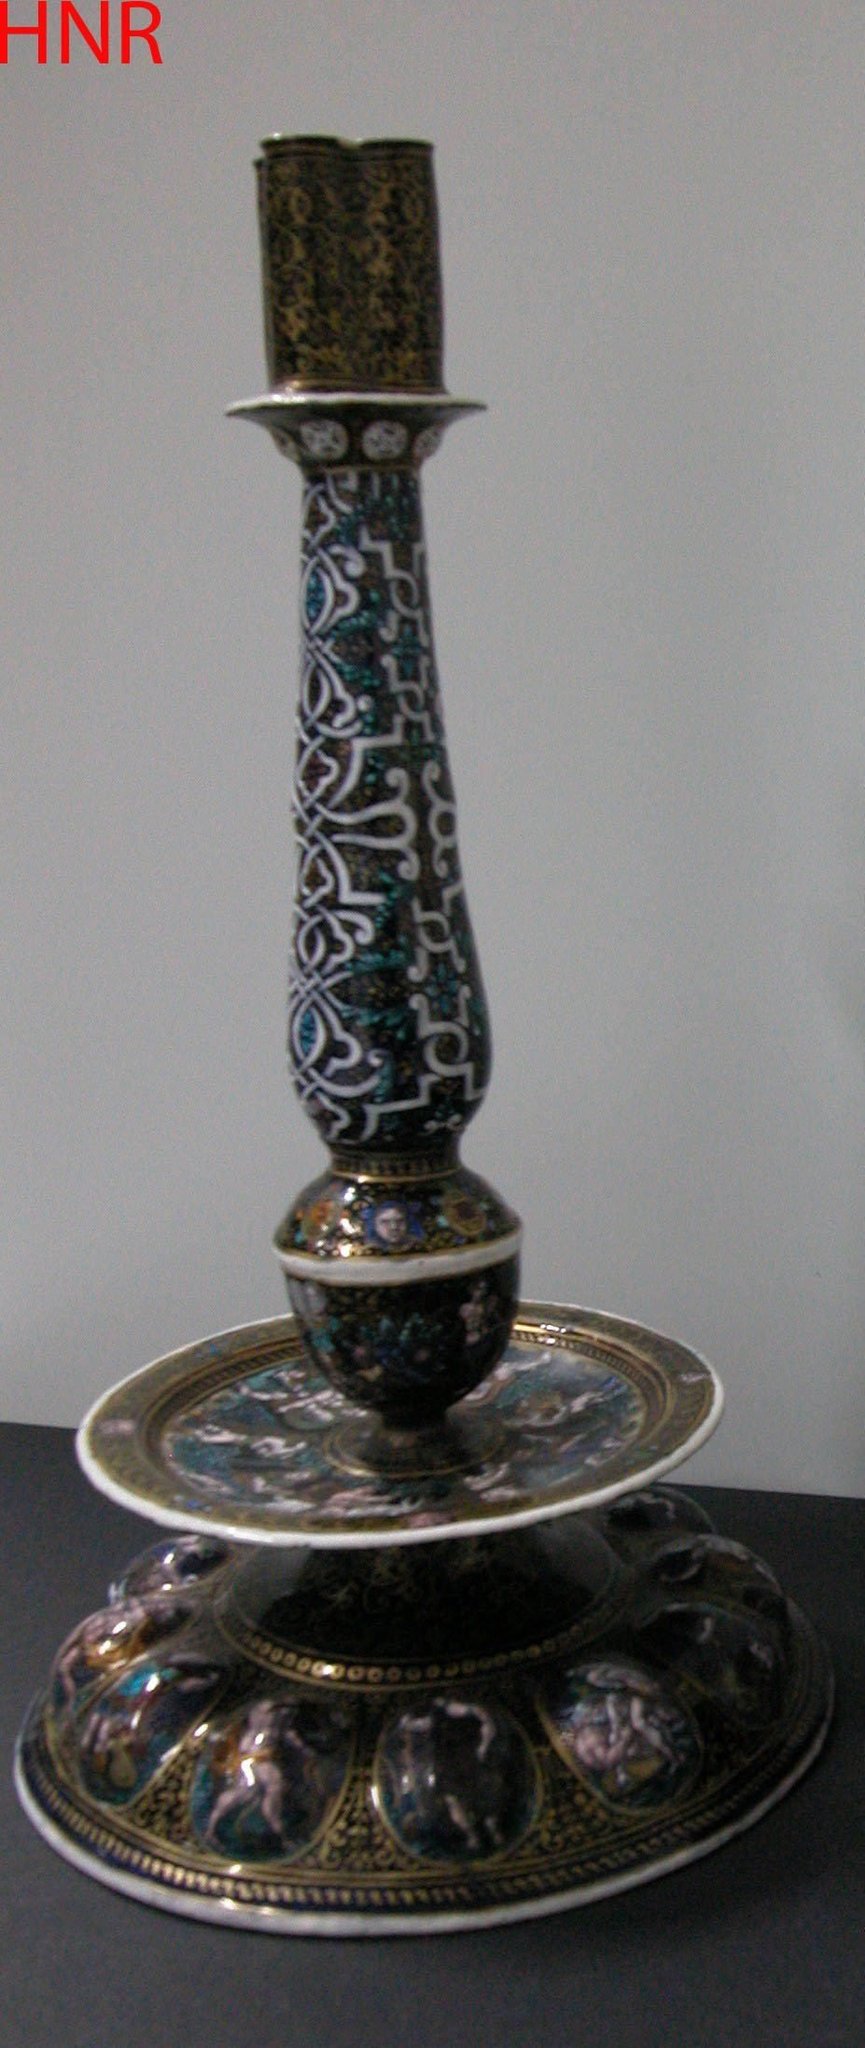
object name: candlestick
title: Pair of candlesticks with gods and the Labours of Hercules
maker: jean court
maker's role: emailleschilder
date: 1550-1600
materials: copper, gold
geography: limoges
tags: most important deeds of hercules: the twelve labours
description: Represented on the round base of the candlesticks are the labours of the Greek hero Hercules, alternating, with depictions of Greek gods.